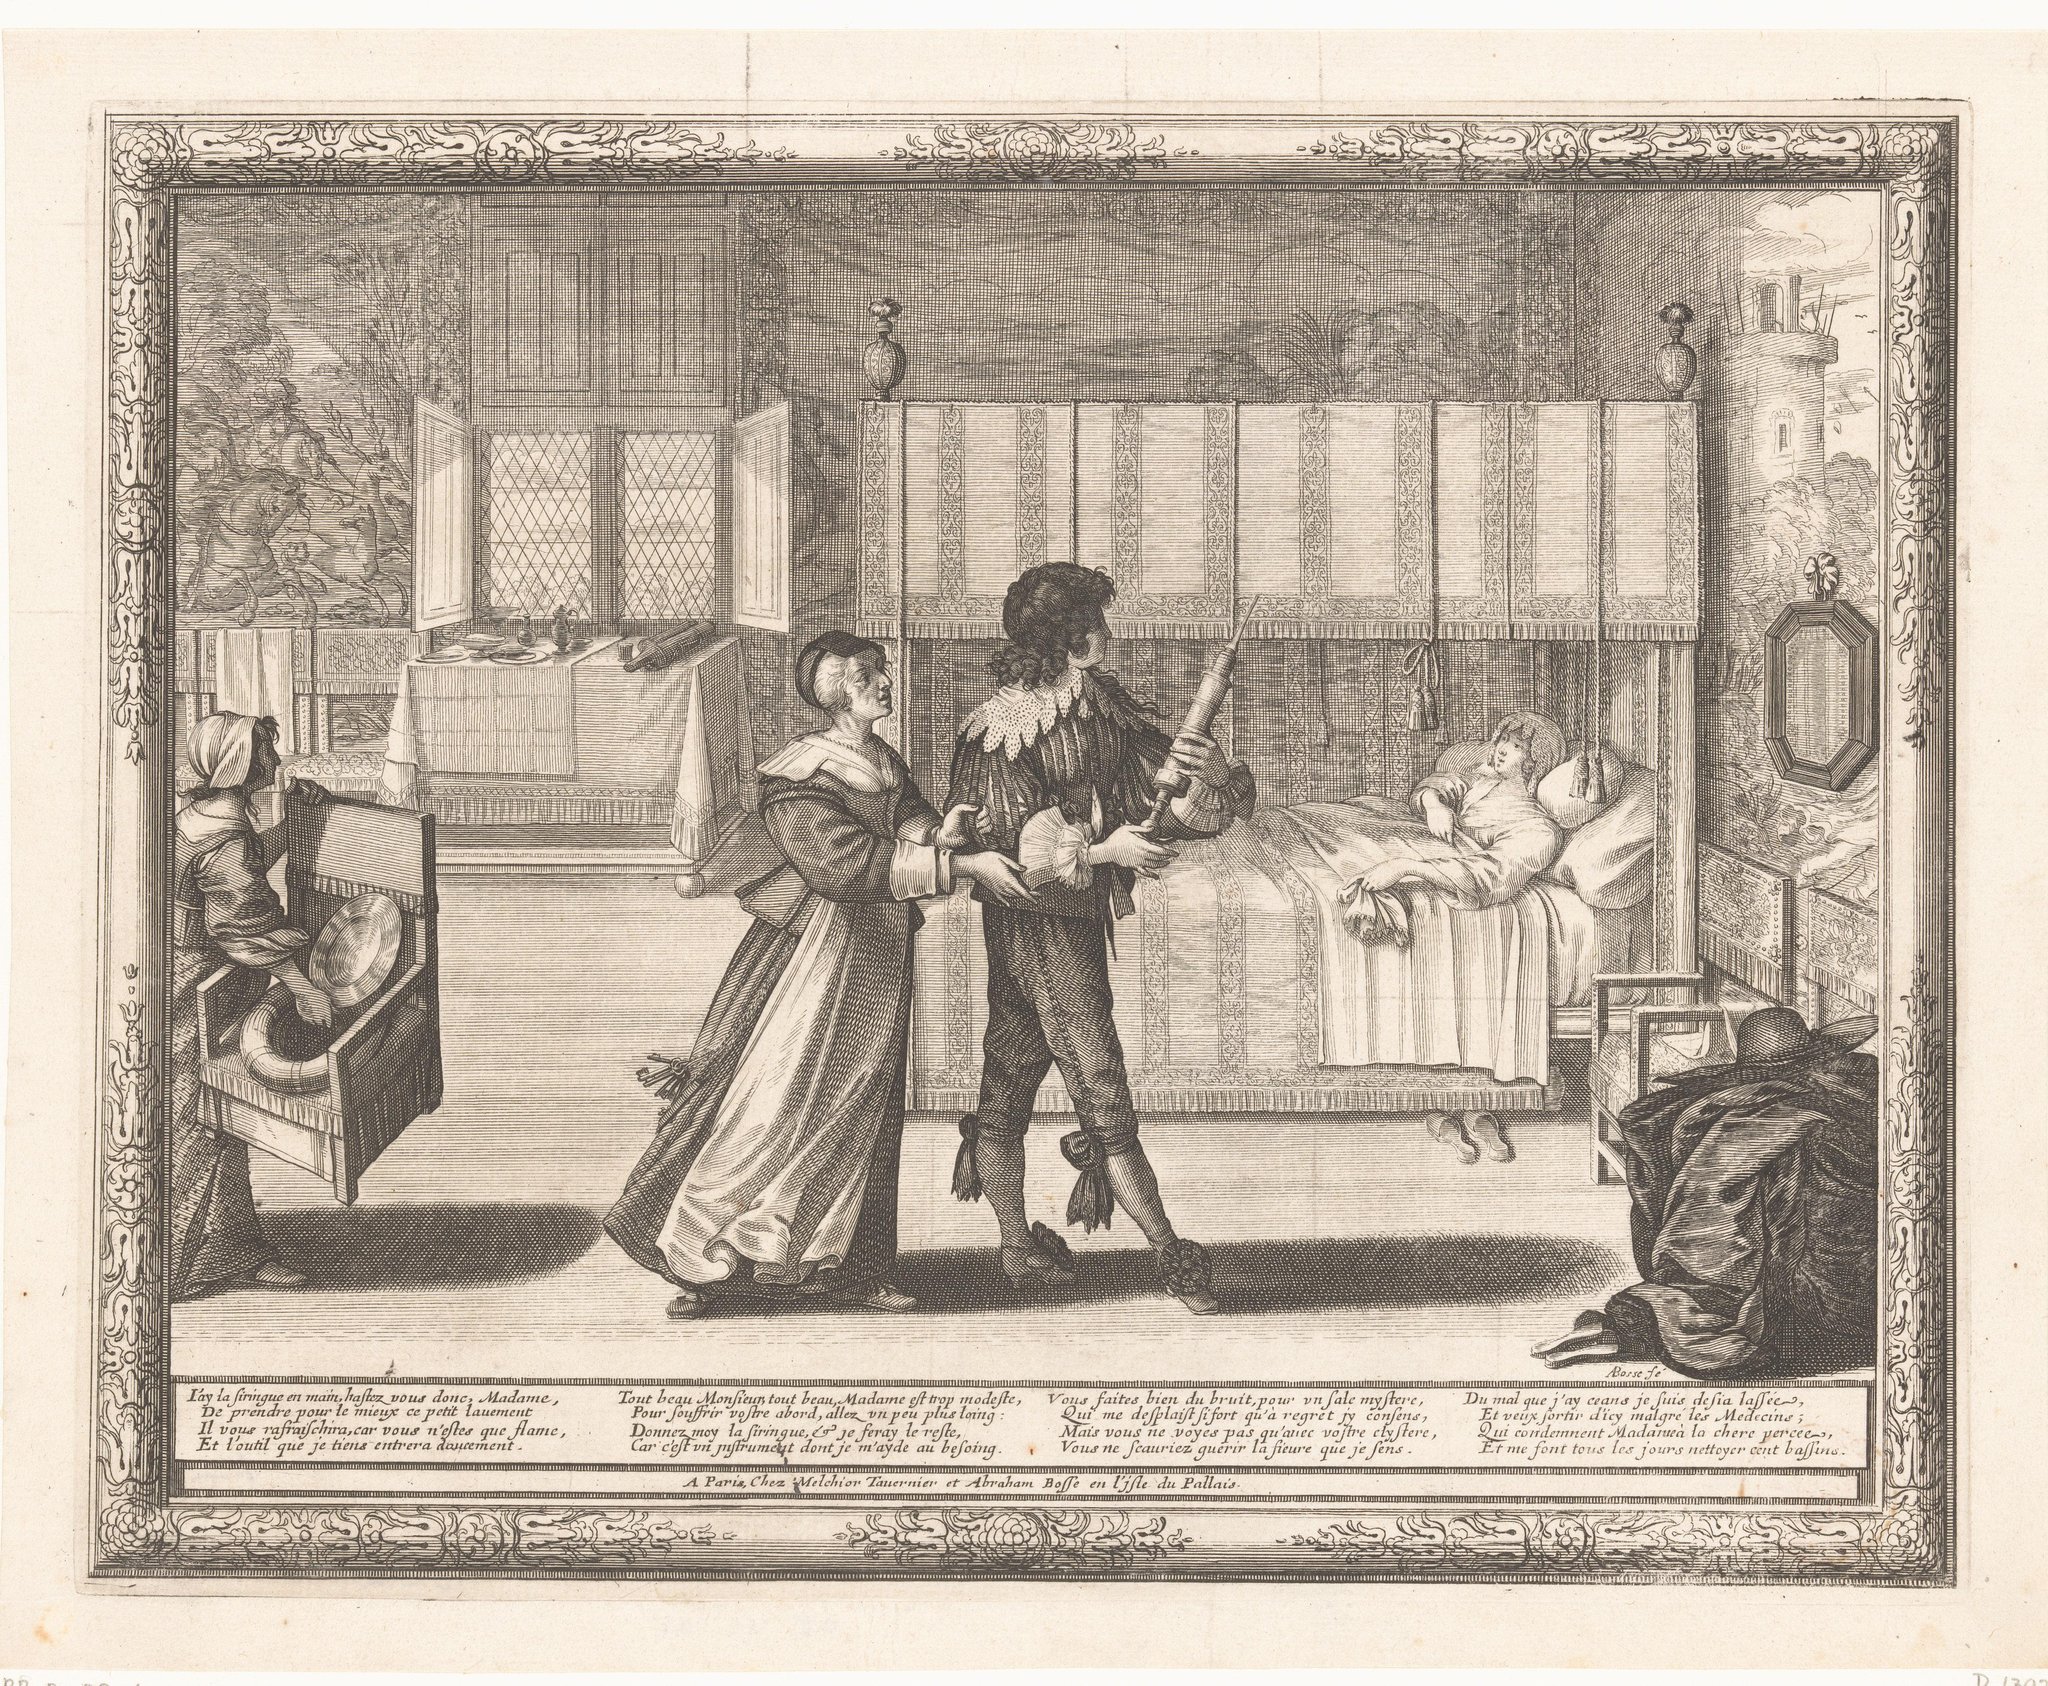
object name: print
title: Apotheker met klisteerspuit bij een vrouw op bed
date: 1636-1637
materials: paper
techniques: engraving, etching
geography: paris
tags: physician, doctor, injection ~ medicine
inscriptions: collector's mark: Lugt 240